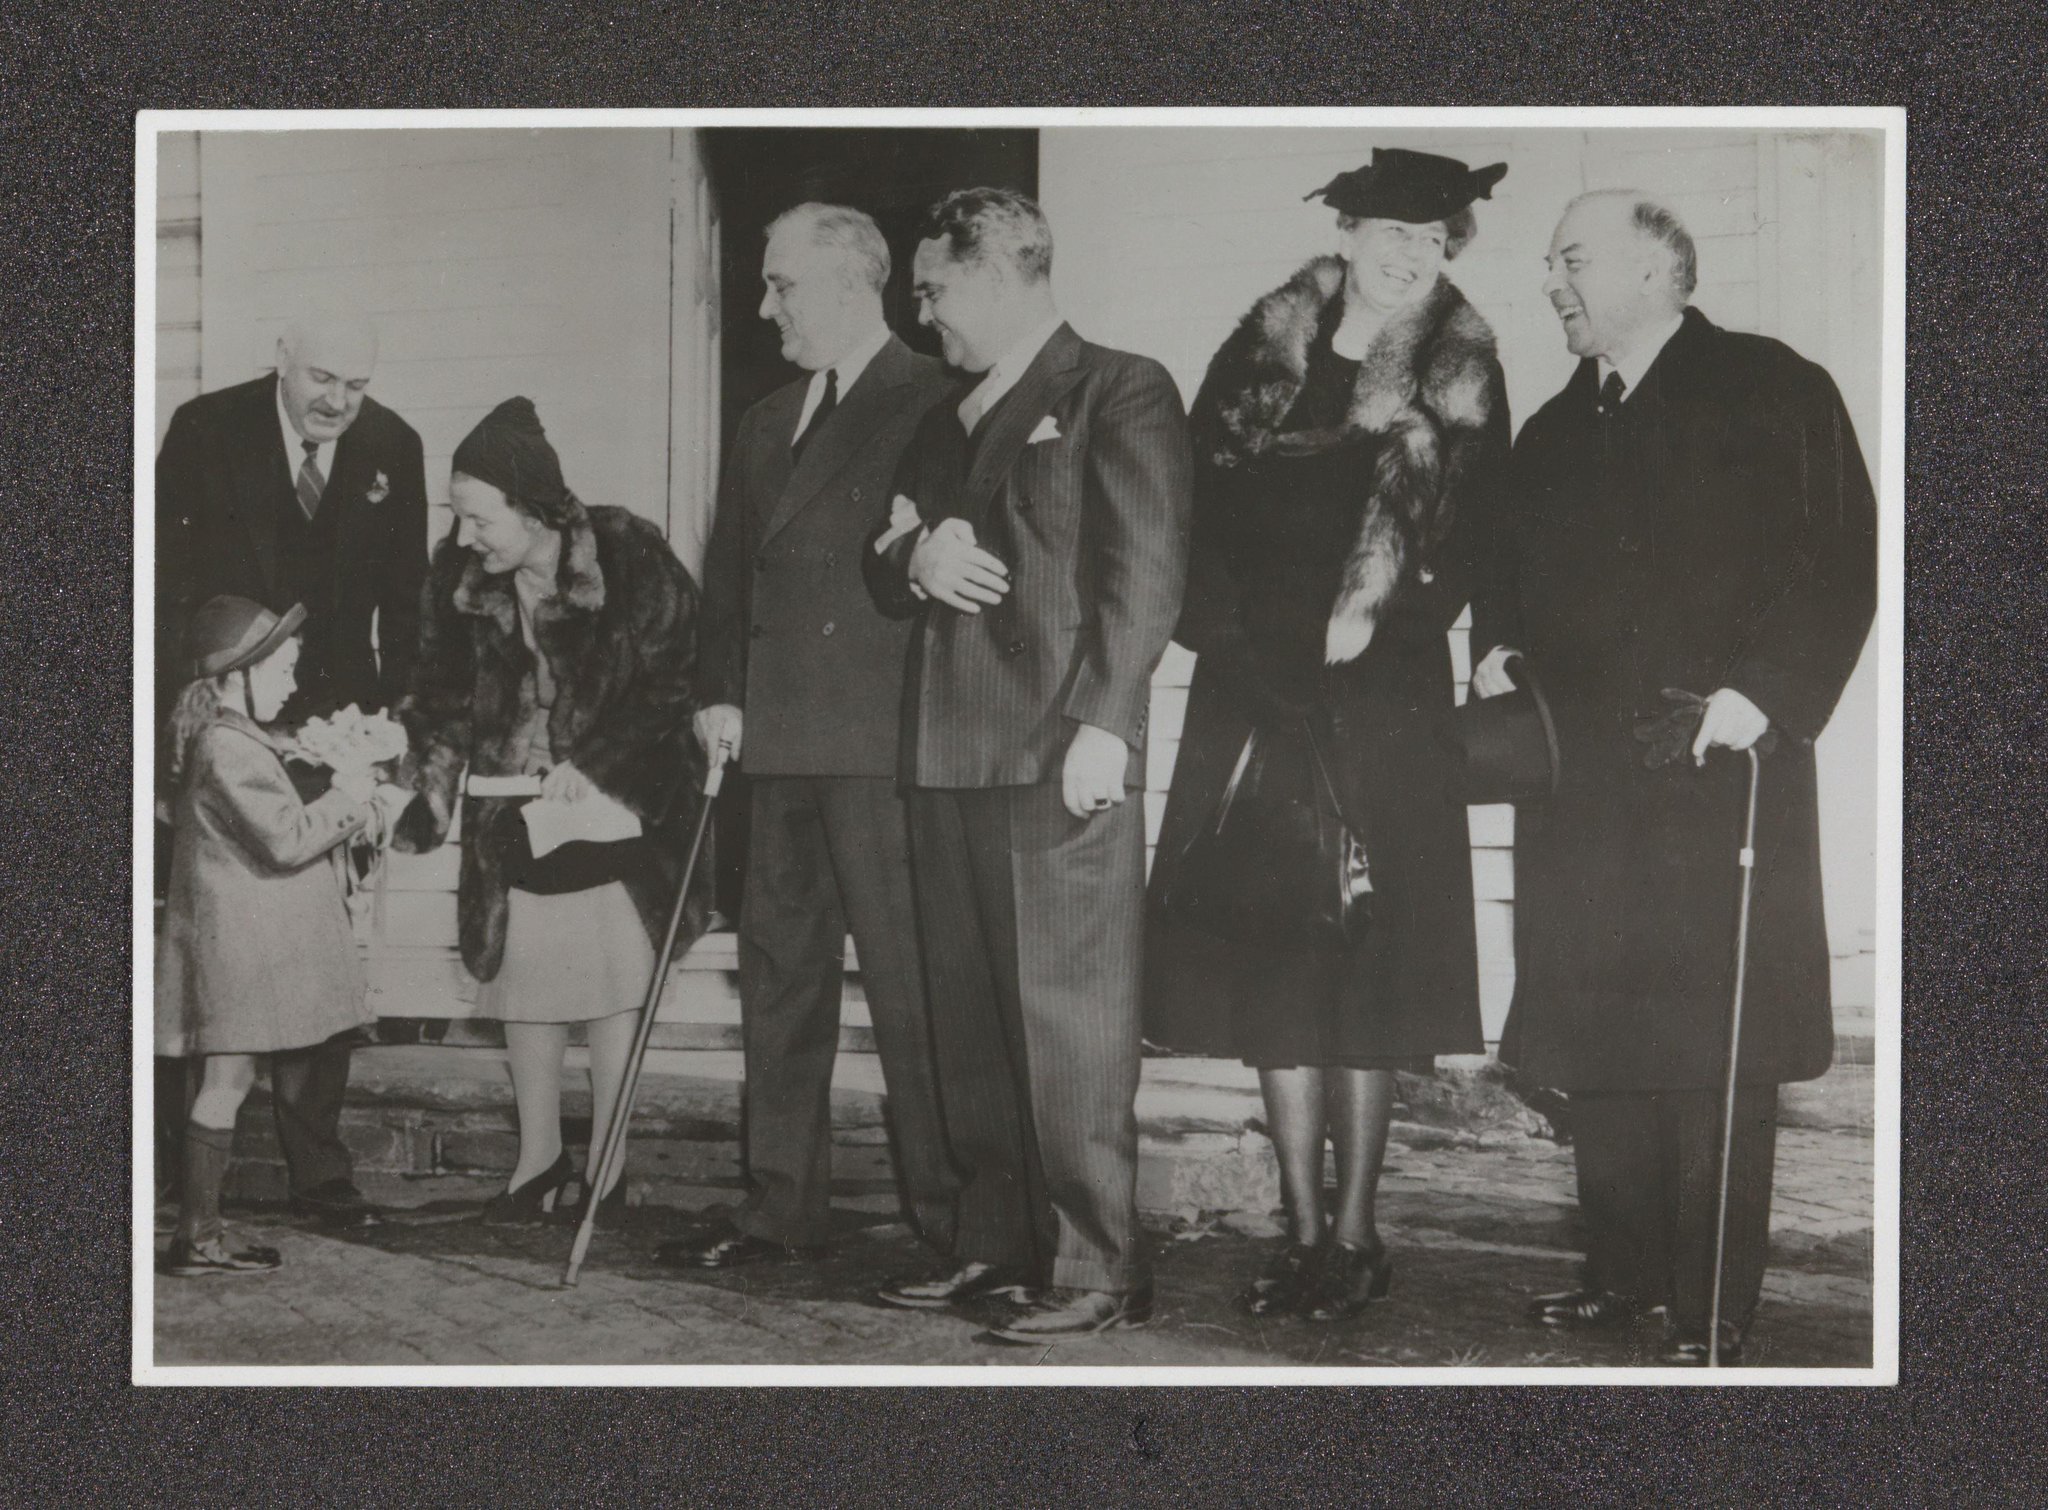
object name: photograph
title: Prinses Juliana ontvangt bloemen bij het verlaten der Hyde Park Dutch Reform Church.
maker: Anonymous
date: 1941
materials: paper, photographic support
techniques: gelatin silver print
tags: new york (city), the hague, juliana of the netherlands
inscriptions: annotation: ‘Prinses Juliana ontvangt bloemen bij het verlaten der Hyde Park Dutch Reform Church. President Roosevelt, Mevr. Roosevelt en Mackenzie King’